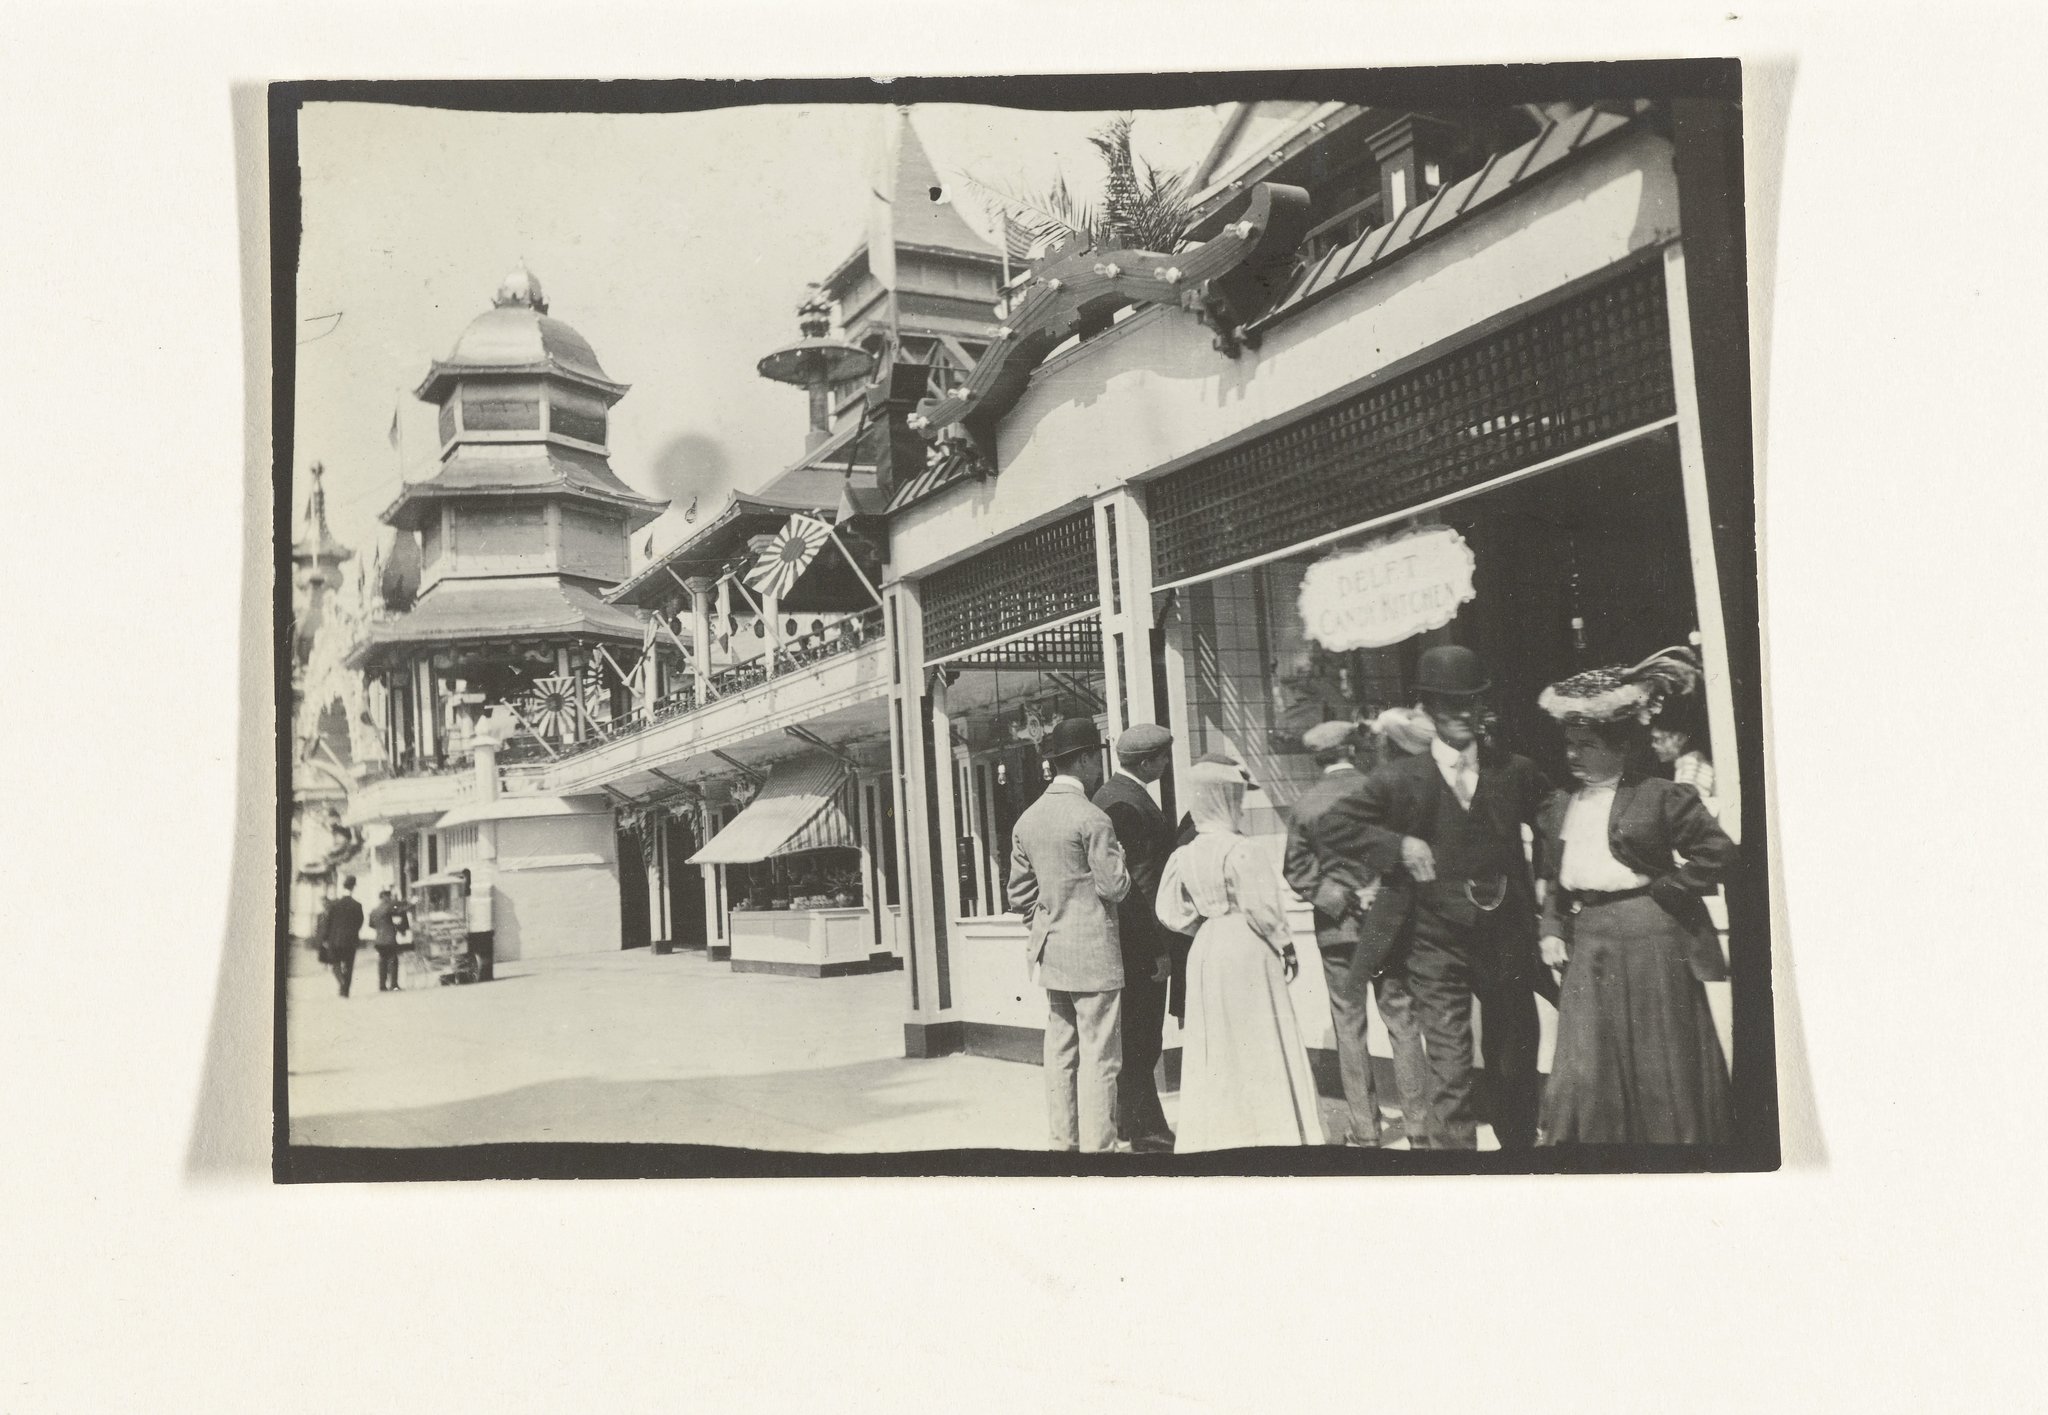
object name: photograph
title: Coney Island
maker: geldolph adriaan kessler (dolph)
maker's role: fotograaf, industrieel, voetballer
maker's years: 1884-1945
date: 1905-1908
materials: cardboard, photographic support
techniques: gelatin silver print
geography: new york city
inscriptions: title: ‘Coney Island’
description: Recreatiepark op Coney Island, voor de kraam van Delft Candy Kitchen. Onderdeel van het fotoalbum van Dolph Kessler met opnamen die hij maakte tijdens zijn verblijf in Engeland en op een wereldreis die hij als secretaris van Henri Deterding (directeur Koninklijke Olie) ondernam naar Nederlands-Indië, Japan, China en de Verenigde Staten, tussen 1906 en 1908.